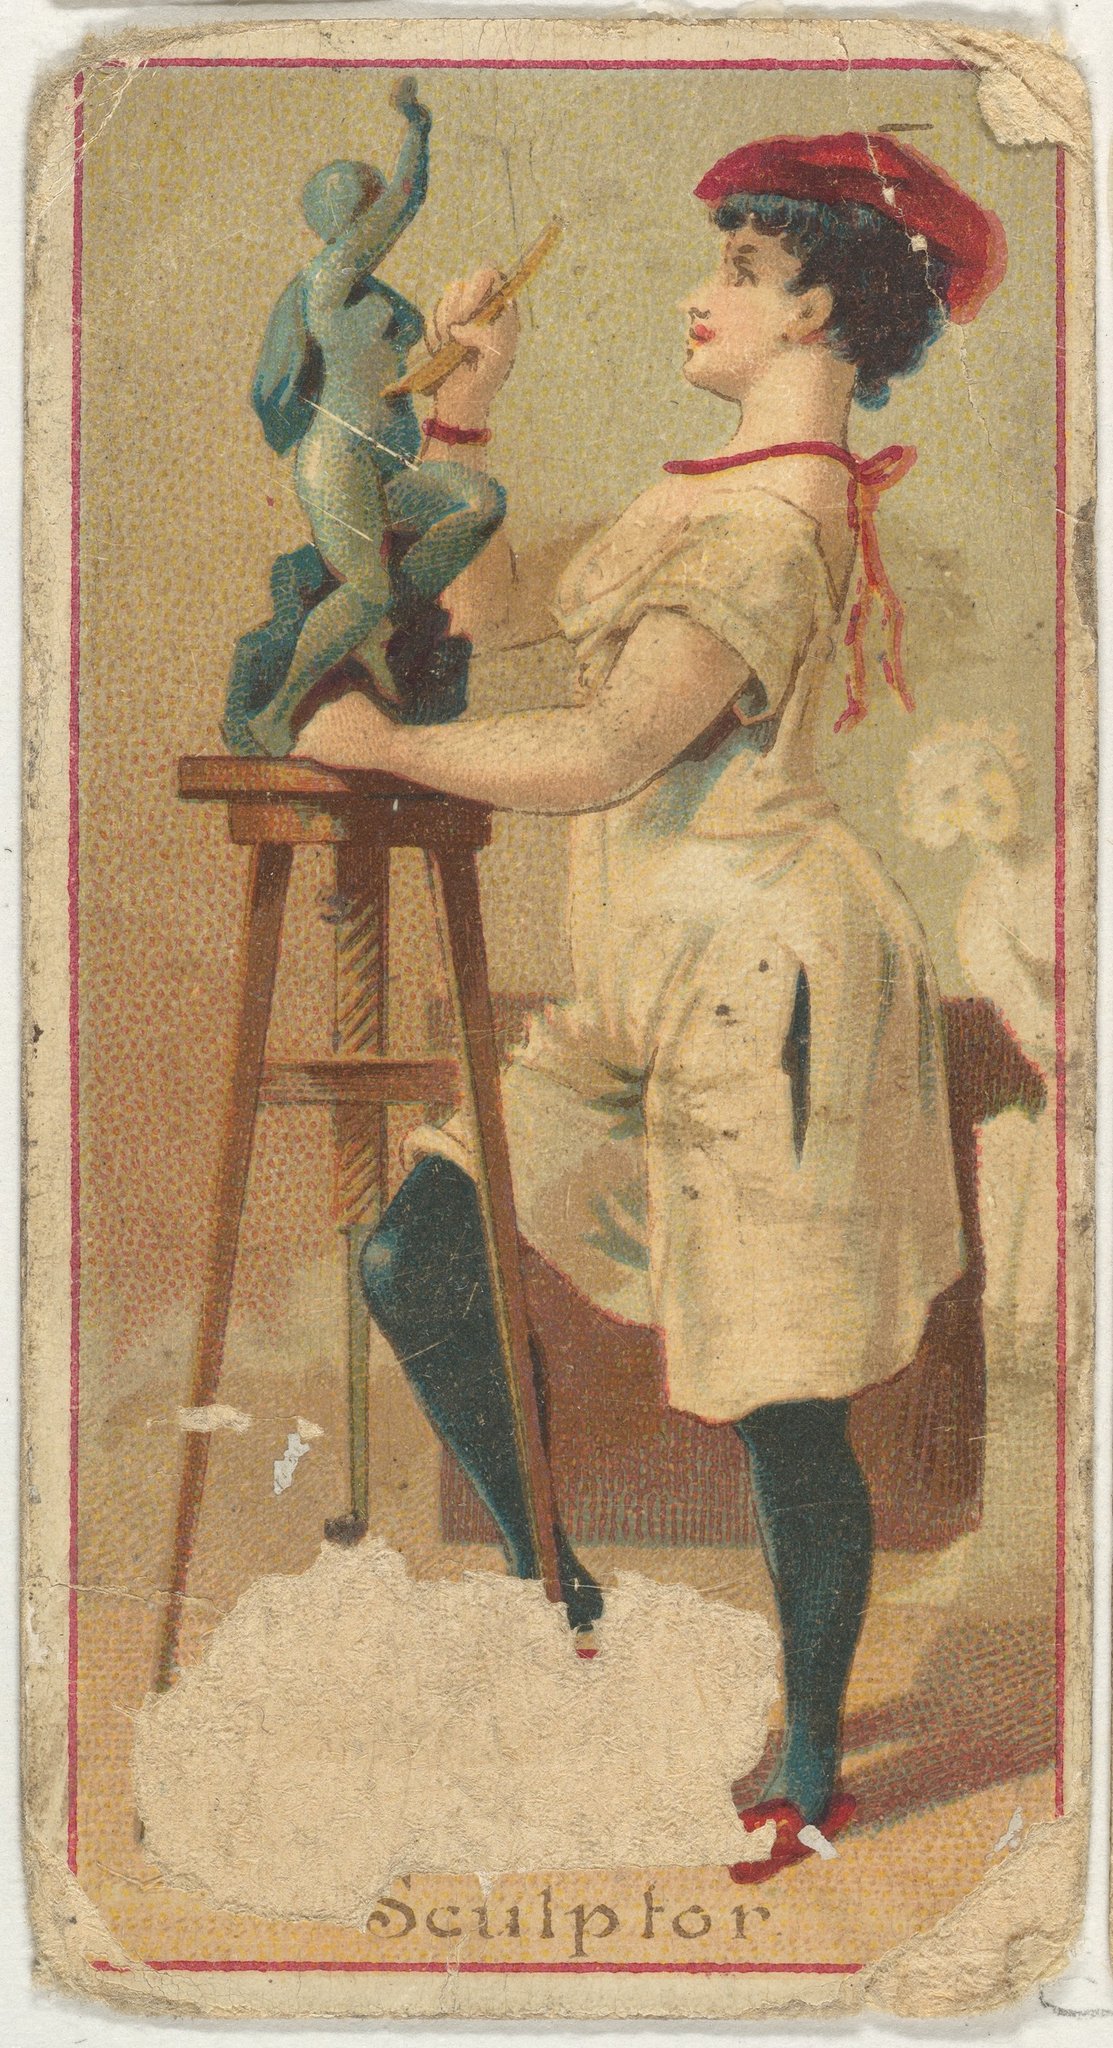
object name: print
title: Sculptor, from the Occupations of Women series (N502) for Frishmuth's Tobacco Company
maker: frishmuth's tobacco company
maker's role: publisher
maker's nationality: american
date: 1889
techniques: color lithograph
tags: sculpture,profiles,women